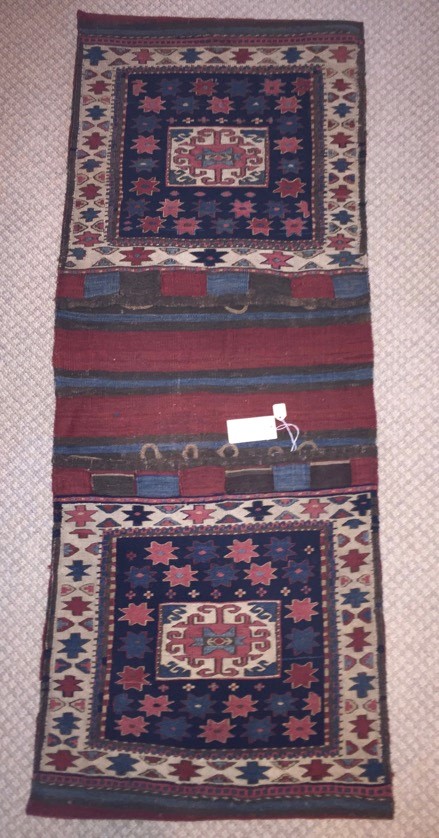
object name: saddle bag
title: Shahsevan Double Saddle Bag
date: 1850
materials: cotton, wool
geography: iran